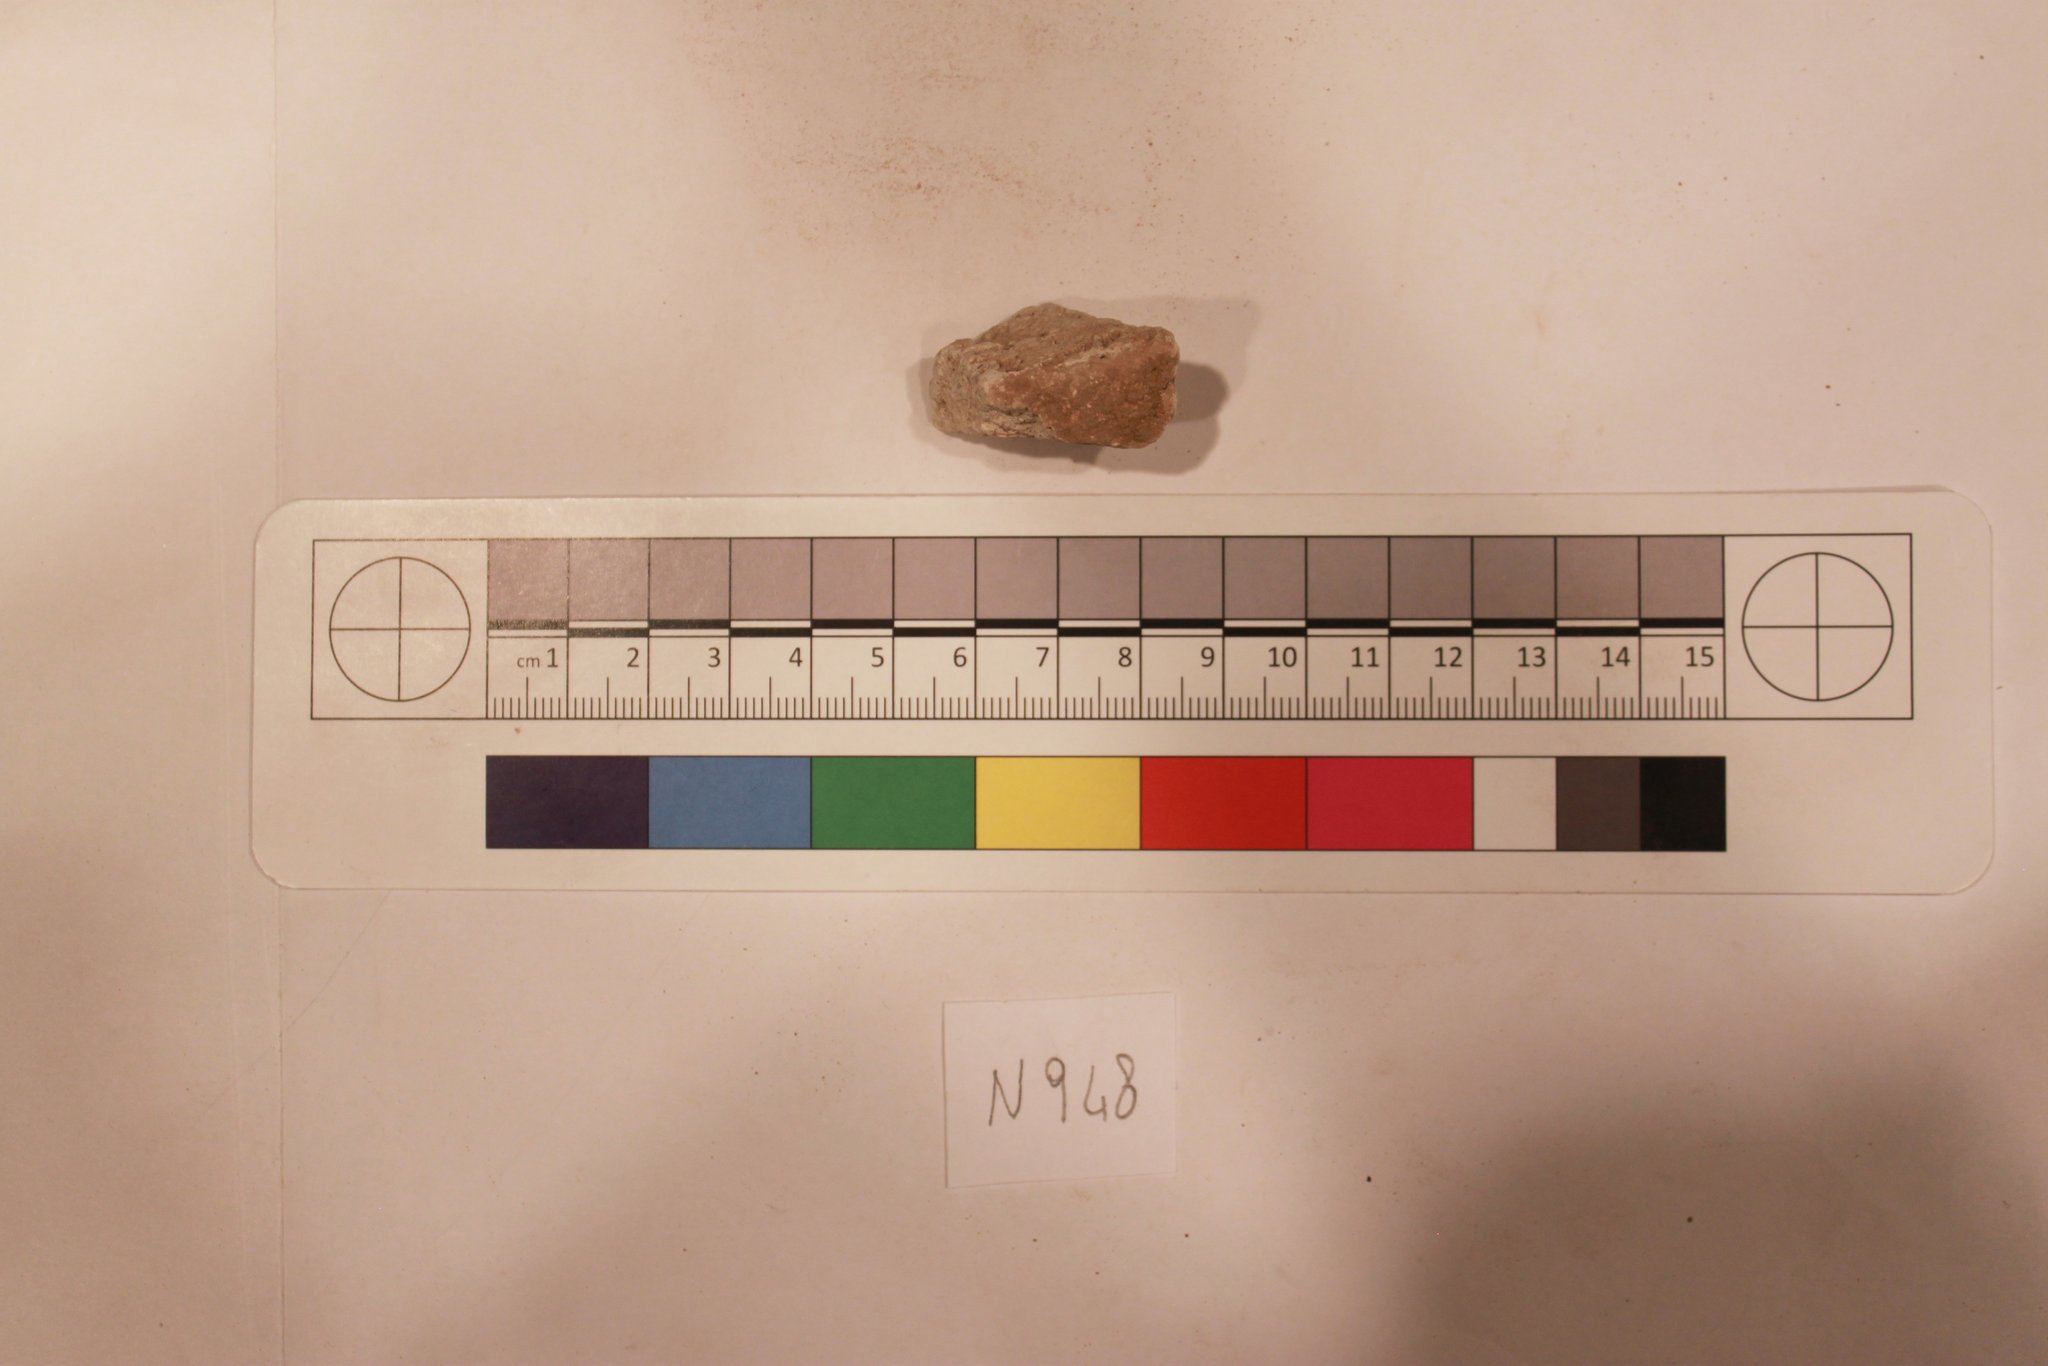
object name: fragment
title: Stucco Fragment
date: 701-1200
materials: plaster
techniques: carving, painting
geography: iran